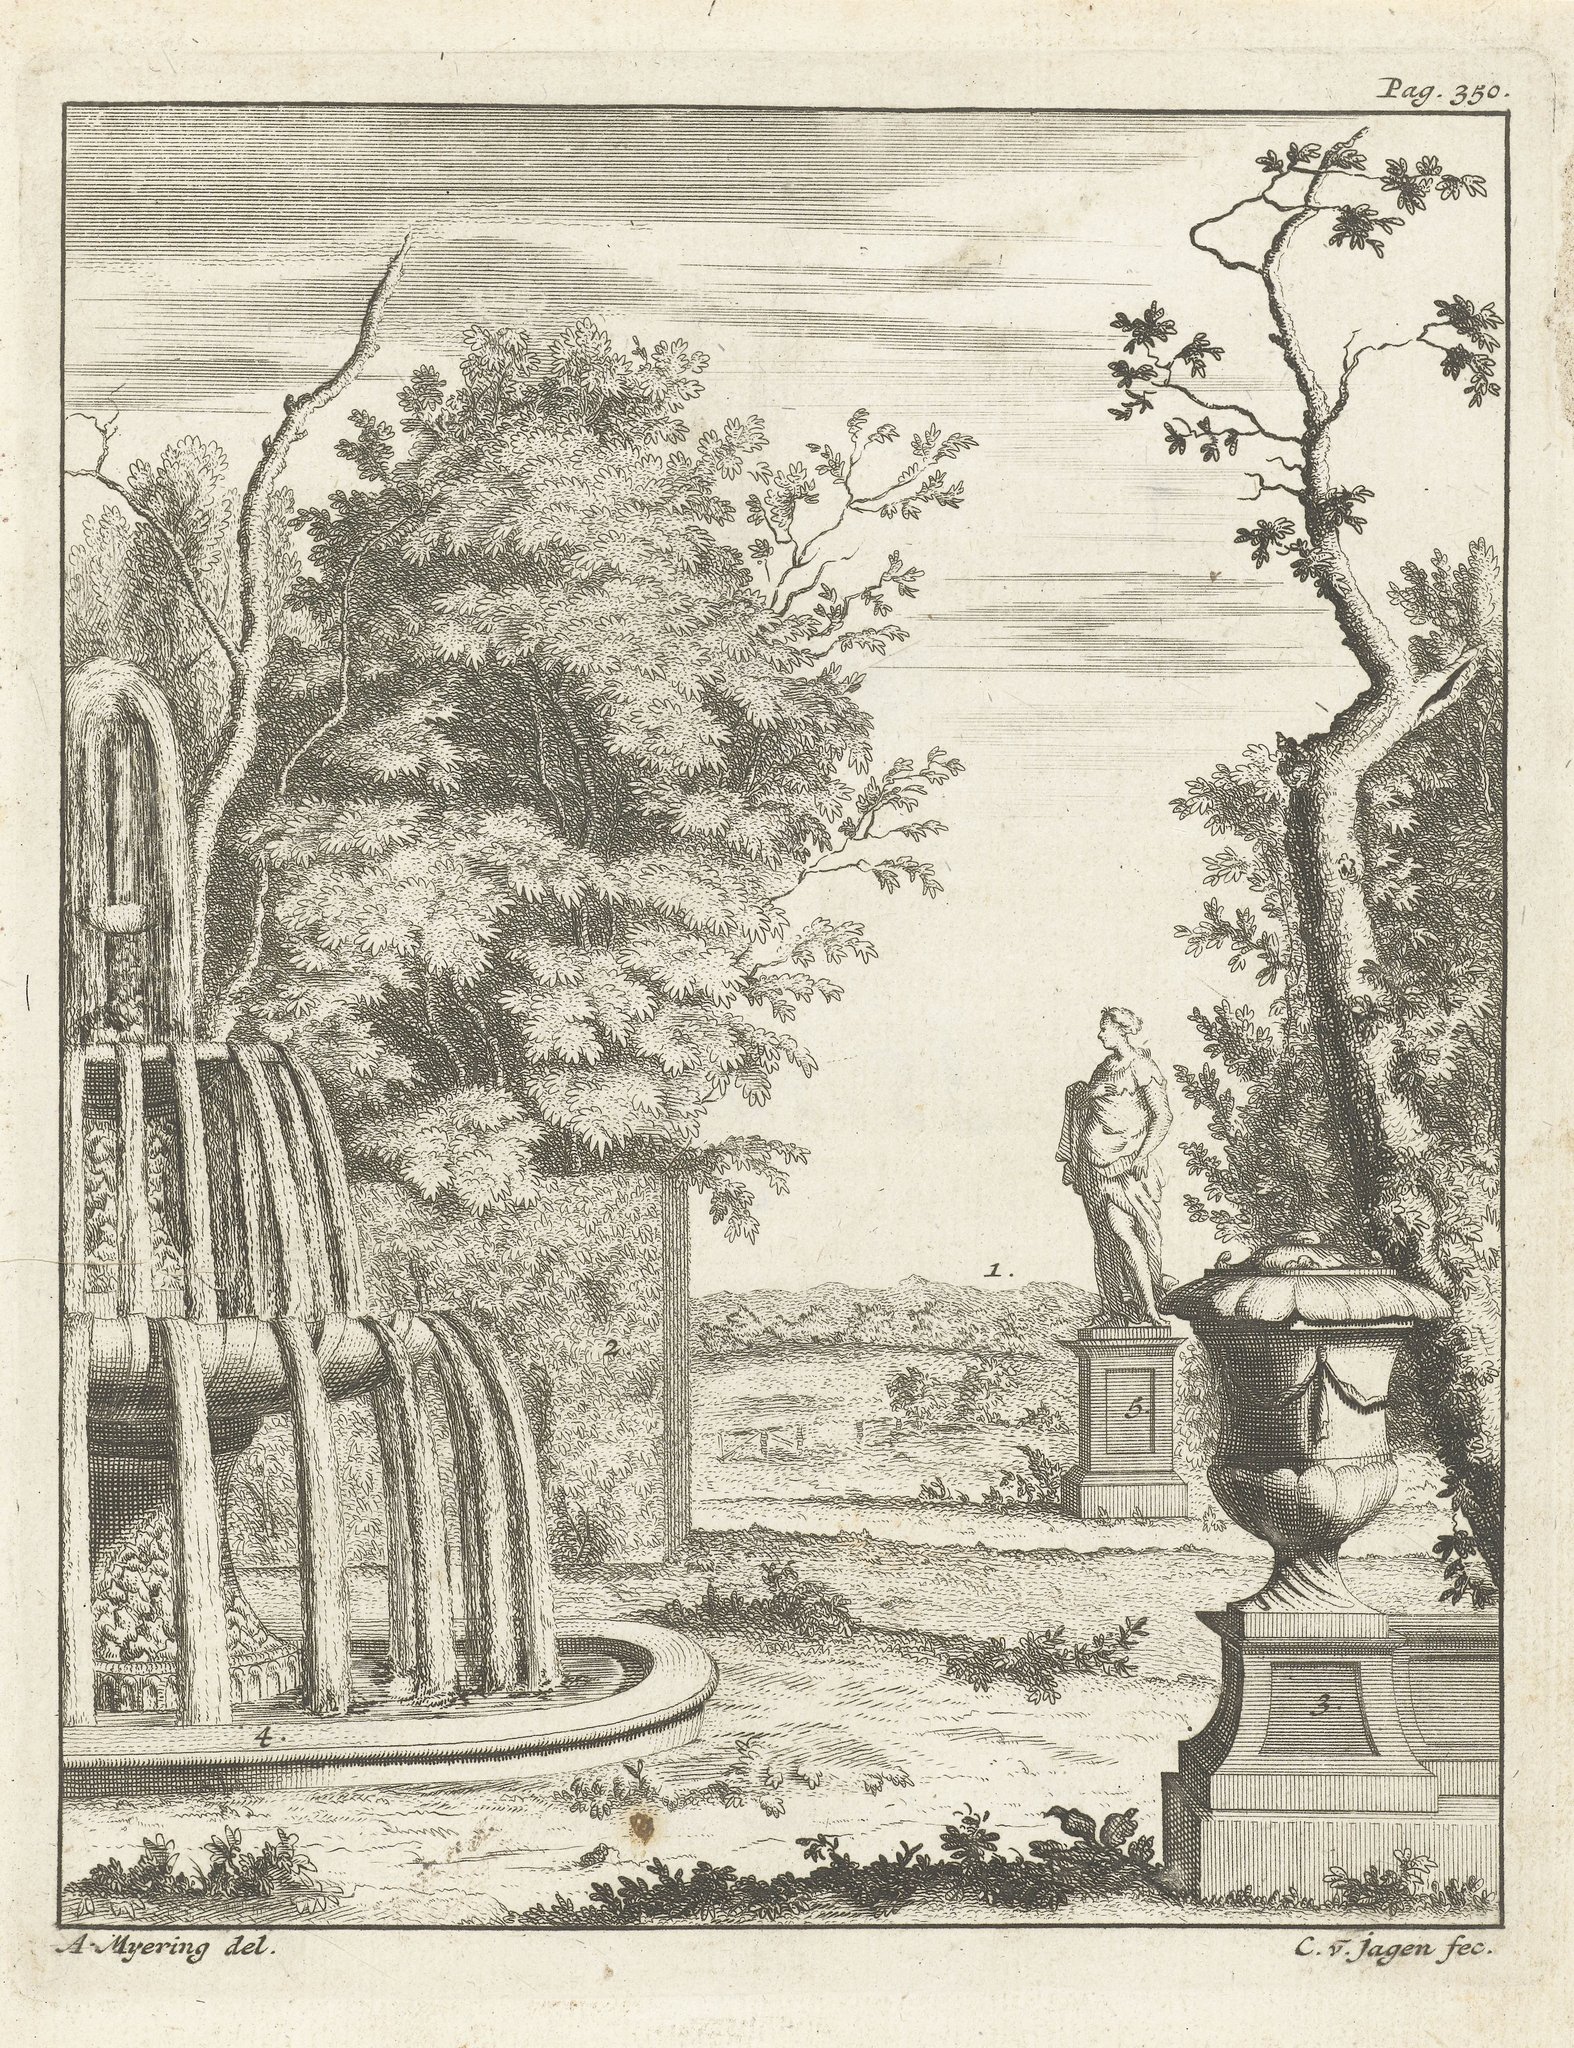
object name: print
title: Landschap met klassieke beelden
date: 1706-1744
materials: paper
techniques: engraving, etching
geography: amsterdam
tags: landscapes - hh - ideal landscapes (+ landscape with figures, staffage)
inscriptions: collector's mark: Lugt 2228, collector's mark: Lugt 2760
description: Landschap met fontein en klassieke beelden, genummerd van 1-5. Rechtsboven: Pag. 350.